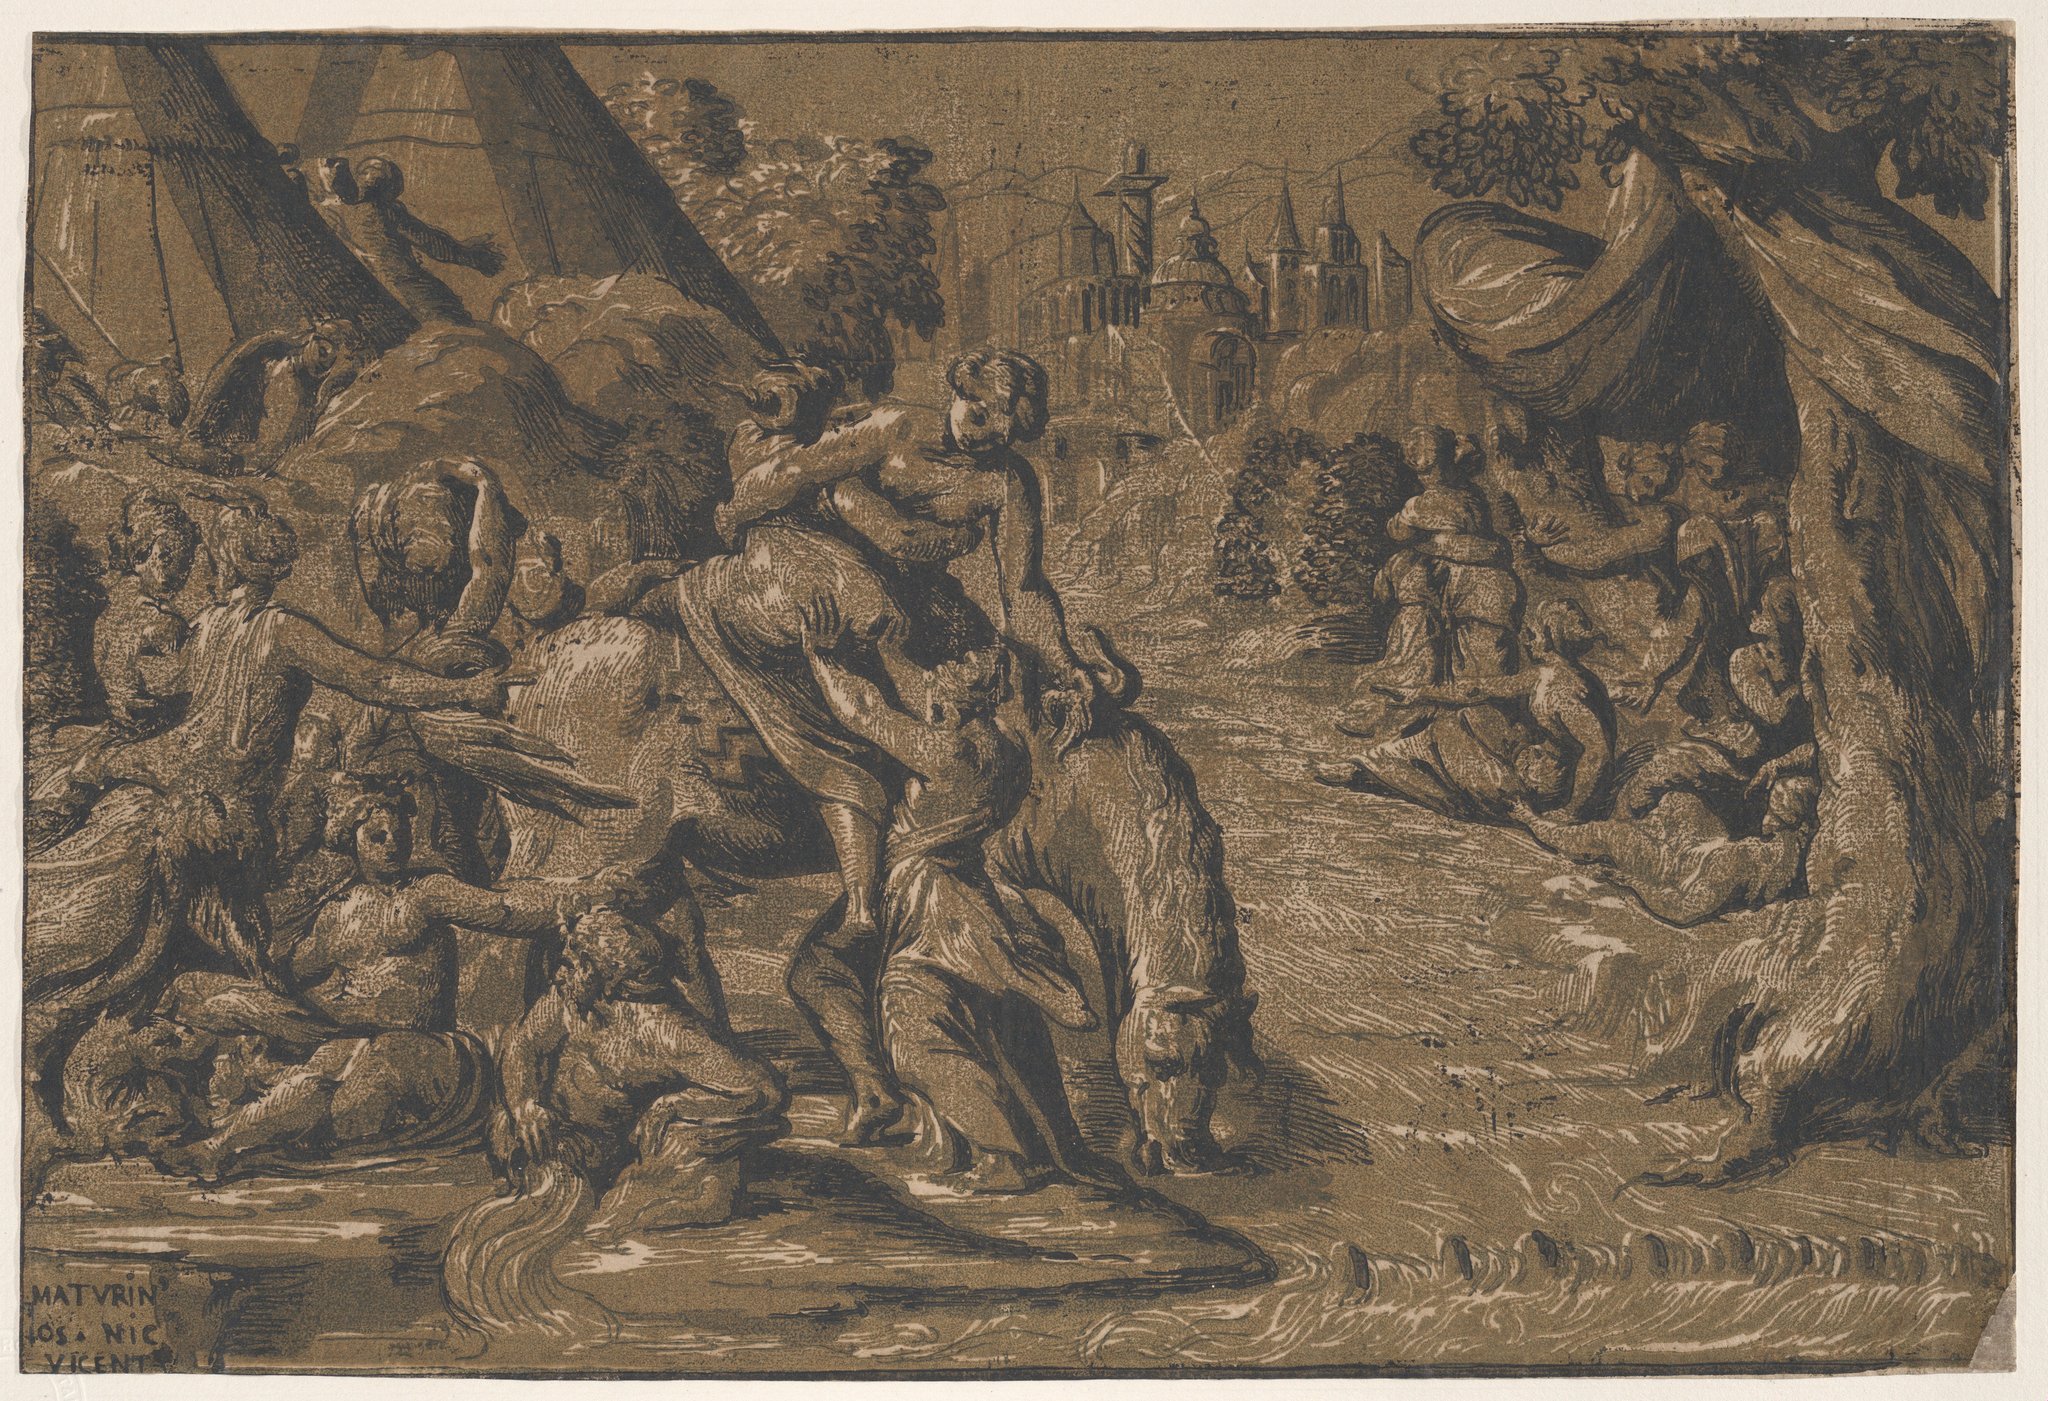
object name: print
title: Cloelia the Roman hero in the centre being helped onto a horse, Rome in the background,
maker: niccolò vicentino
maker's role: artist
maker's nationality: italian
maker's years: 1510-1550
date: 1540-1550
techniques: woodcut